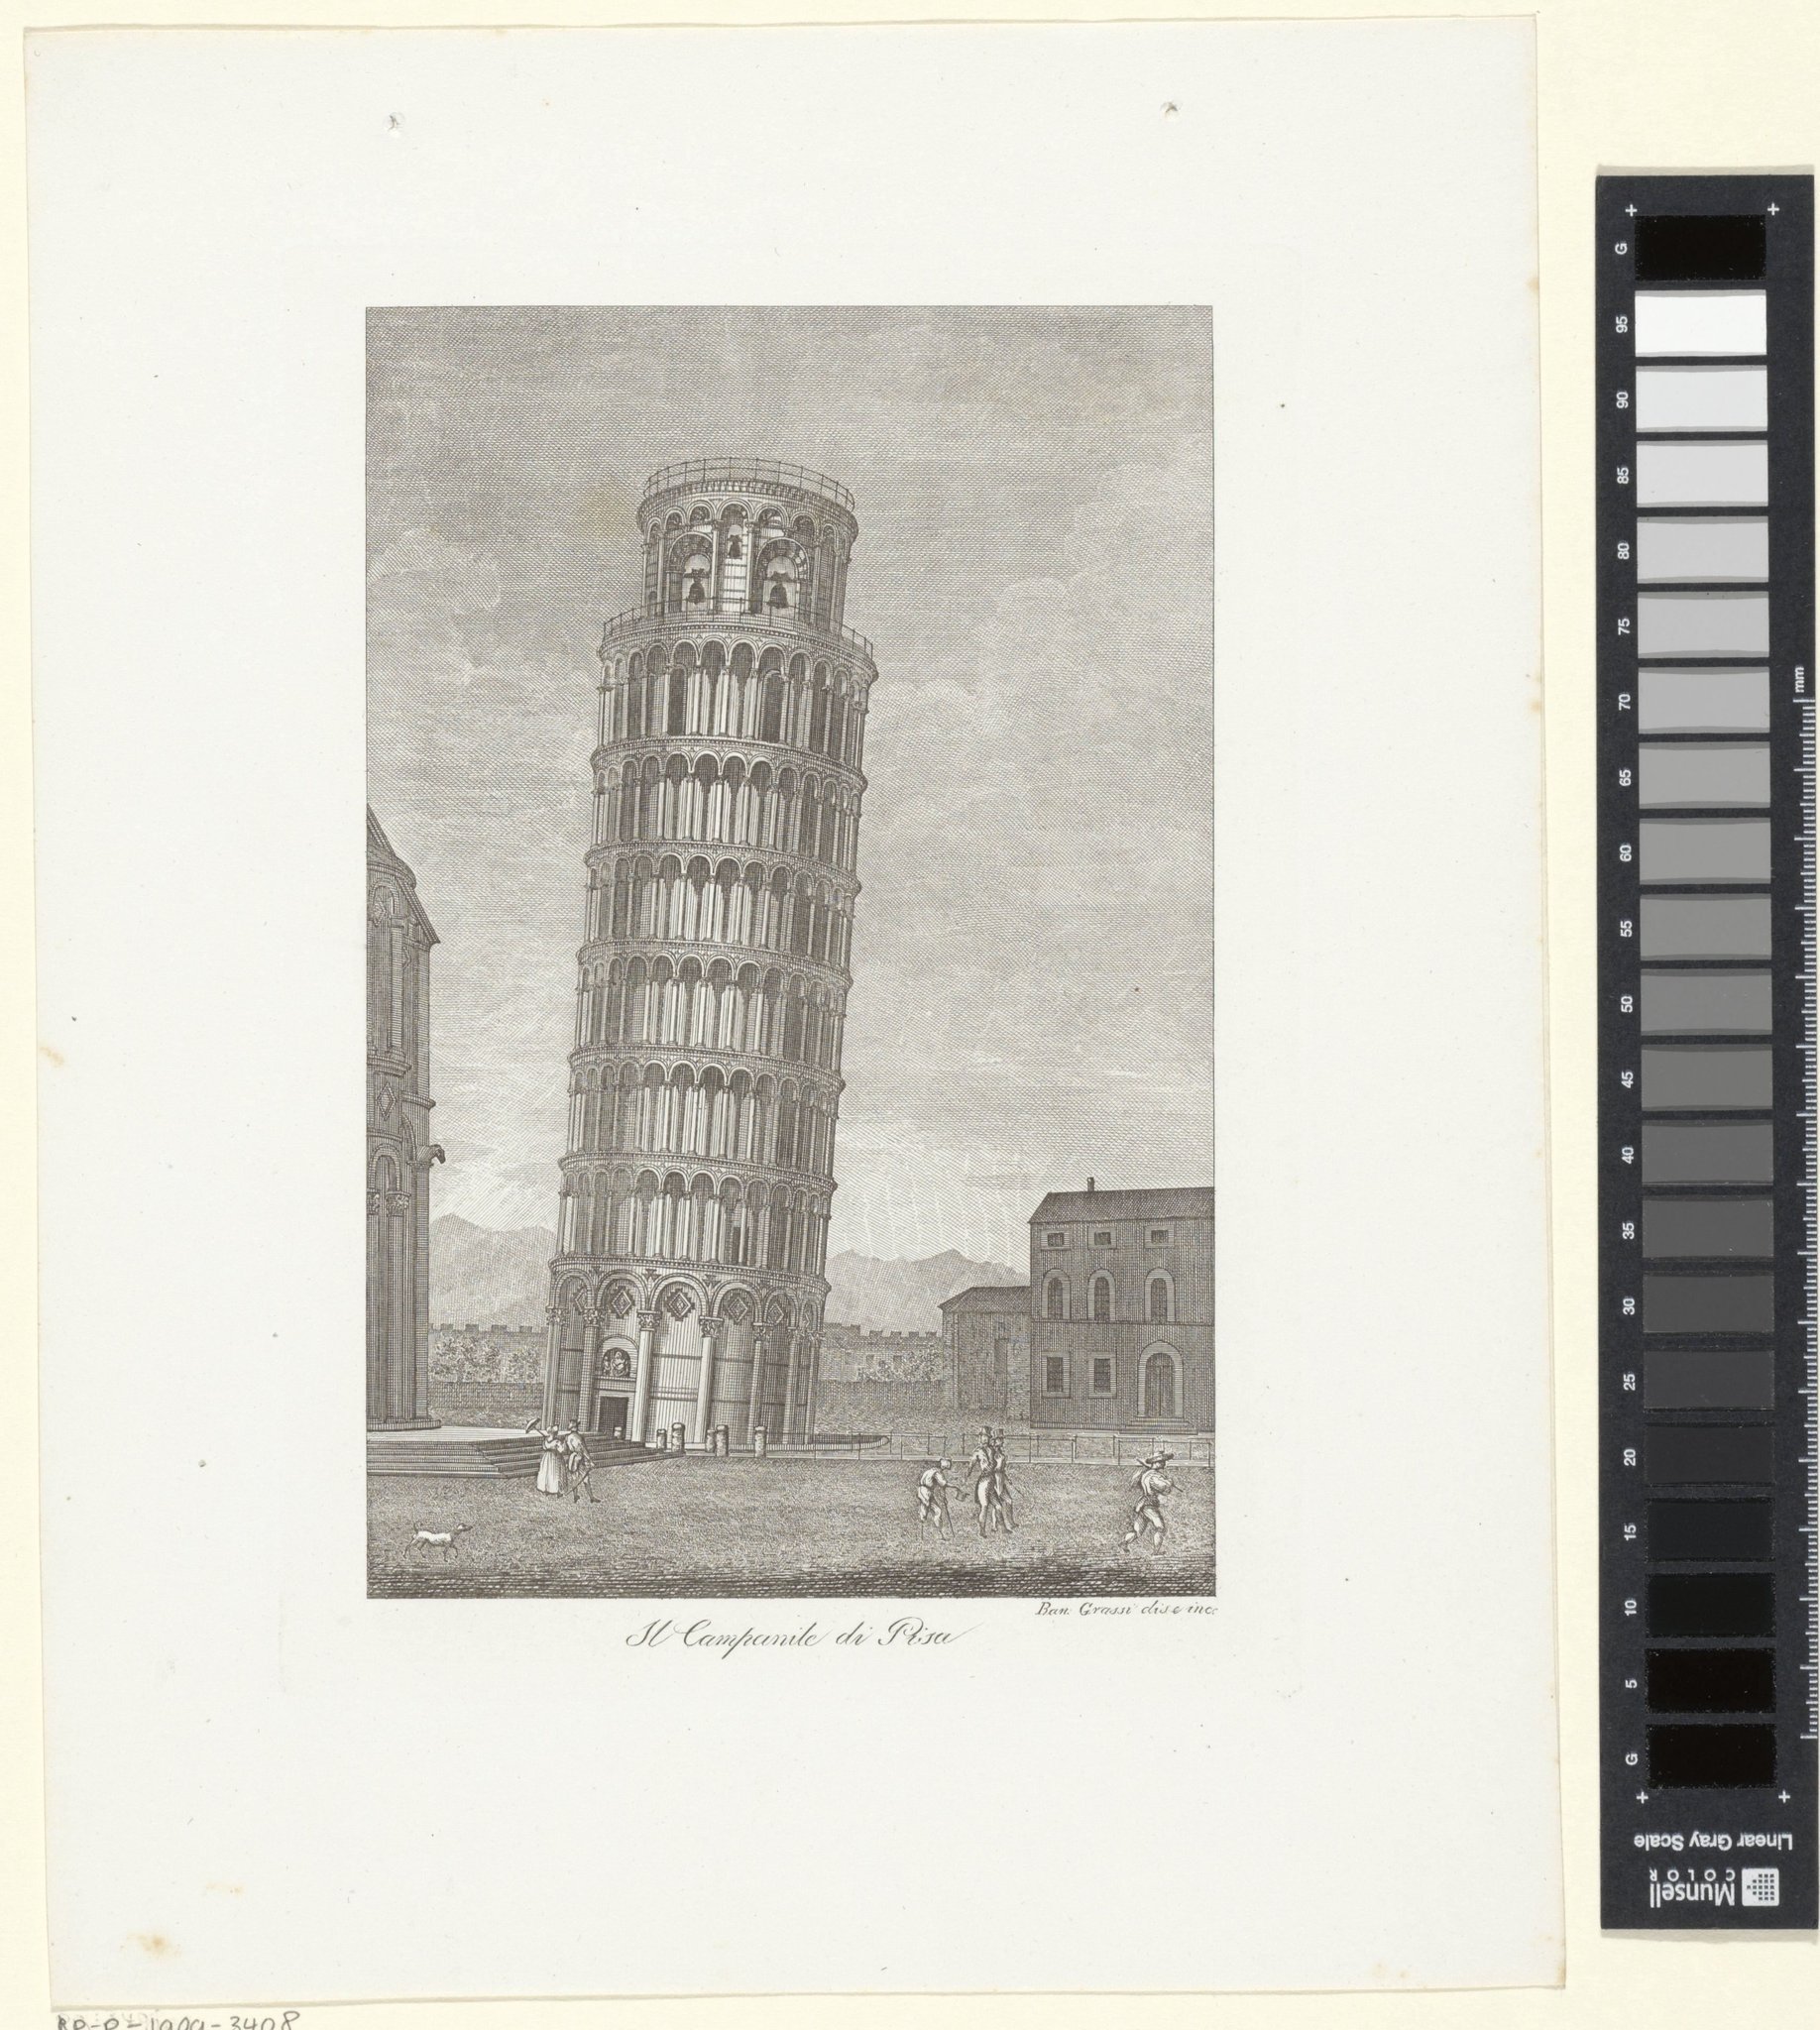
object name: print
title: Voorstellingen van de meeste prominente gebouwen in Pisa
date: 1854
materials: paper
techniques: etching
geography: pisa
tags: parts of church exterior and annexes: campanile, city-view in general; 'veduta'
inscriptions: collector's mark: Lugt 2228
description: Prent 5 uit een reeks van 8 prenten met omslag.